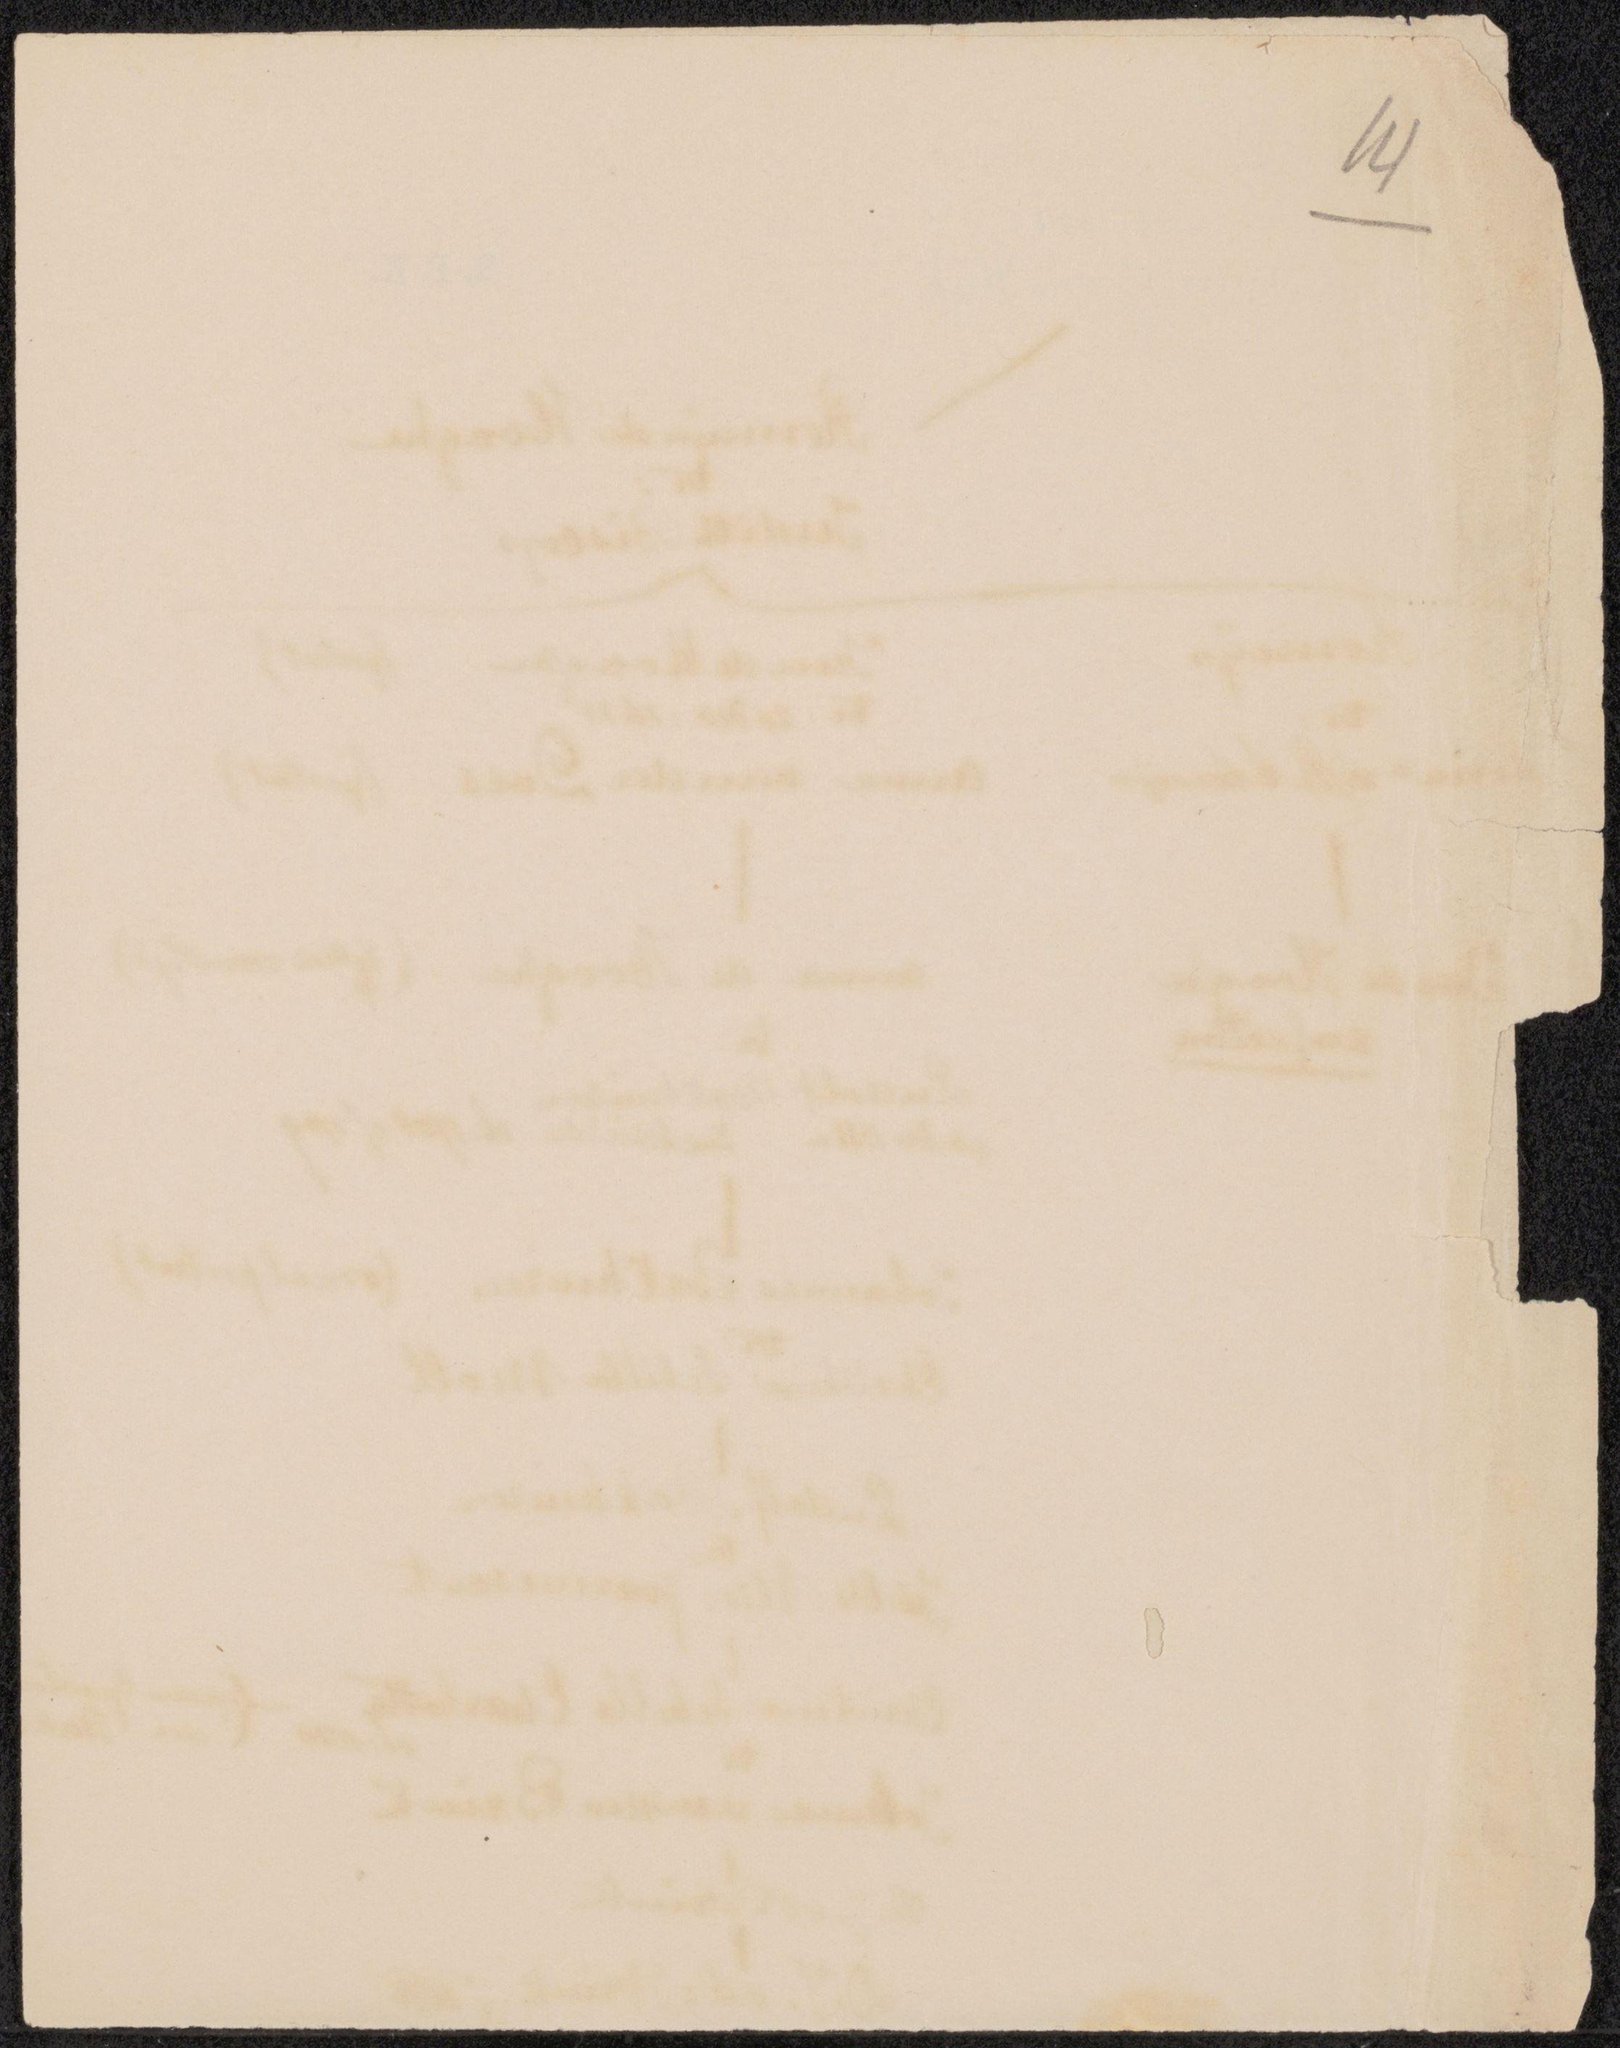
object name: manuscript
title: Handschrift betreffende de stamboom van de familie De Hooghe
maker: Anonymous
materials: ink, paper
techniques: pen, writing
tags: london, amsterdam, johannes de hooghe (1608-1682), ludolf bakhuysen, anna de hooghe, painting (including book-illumination, miniature-painting), historical persons (portraits and scenes from the life)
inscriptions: collector's mark: Lugt 2233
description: Gerelateerde objecten worden mogelijk genoemd in het handschrift.